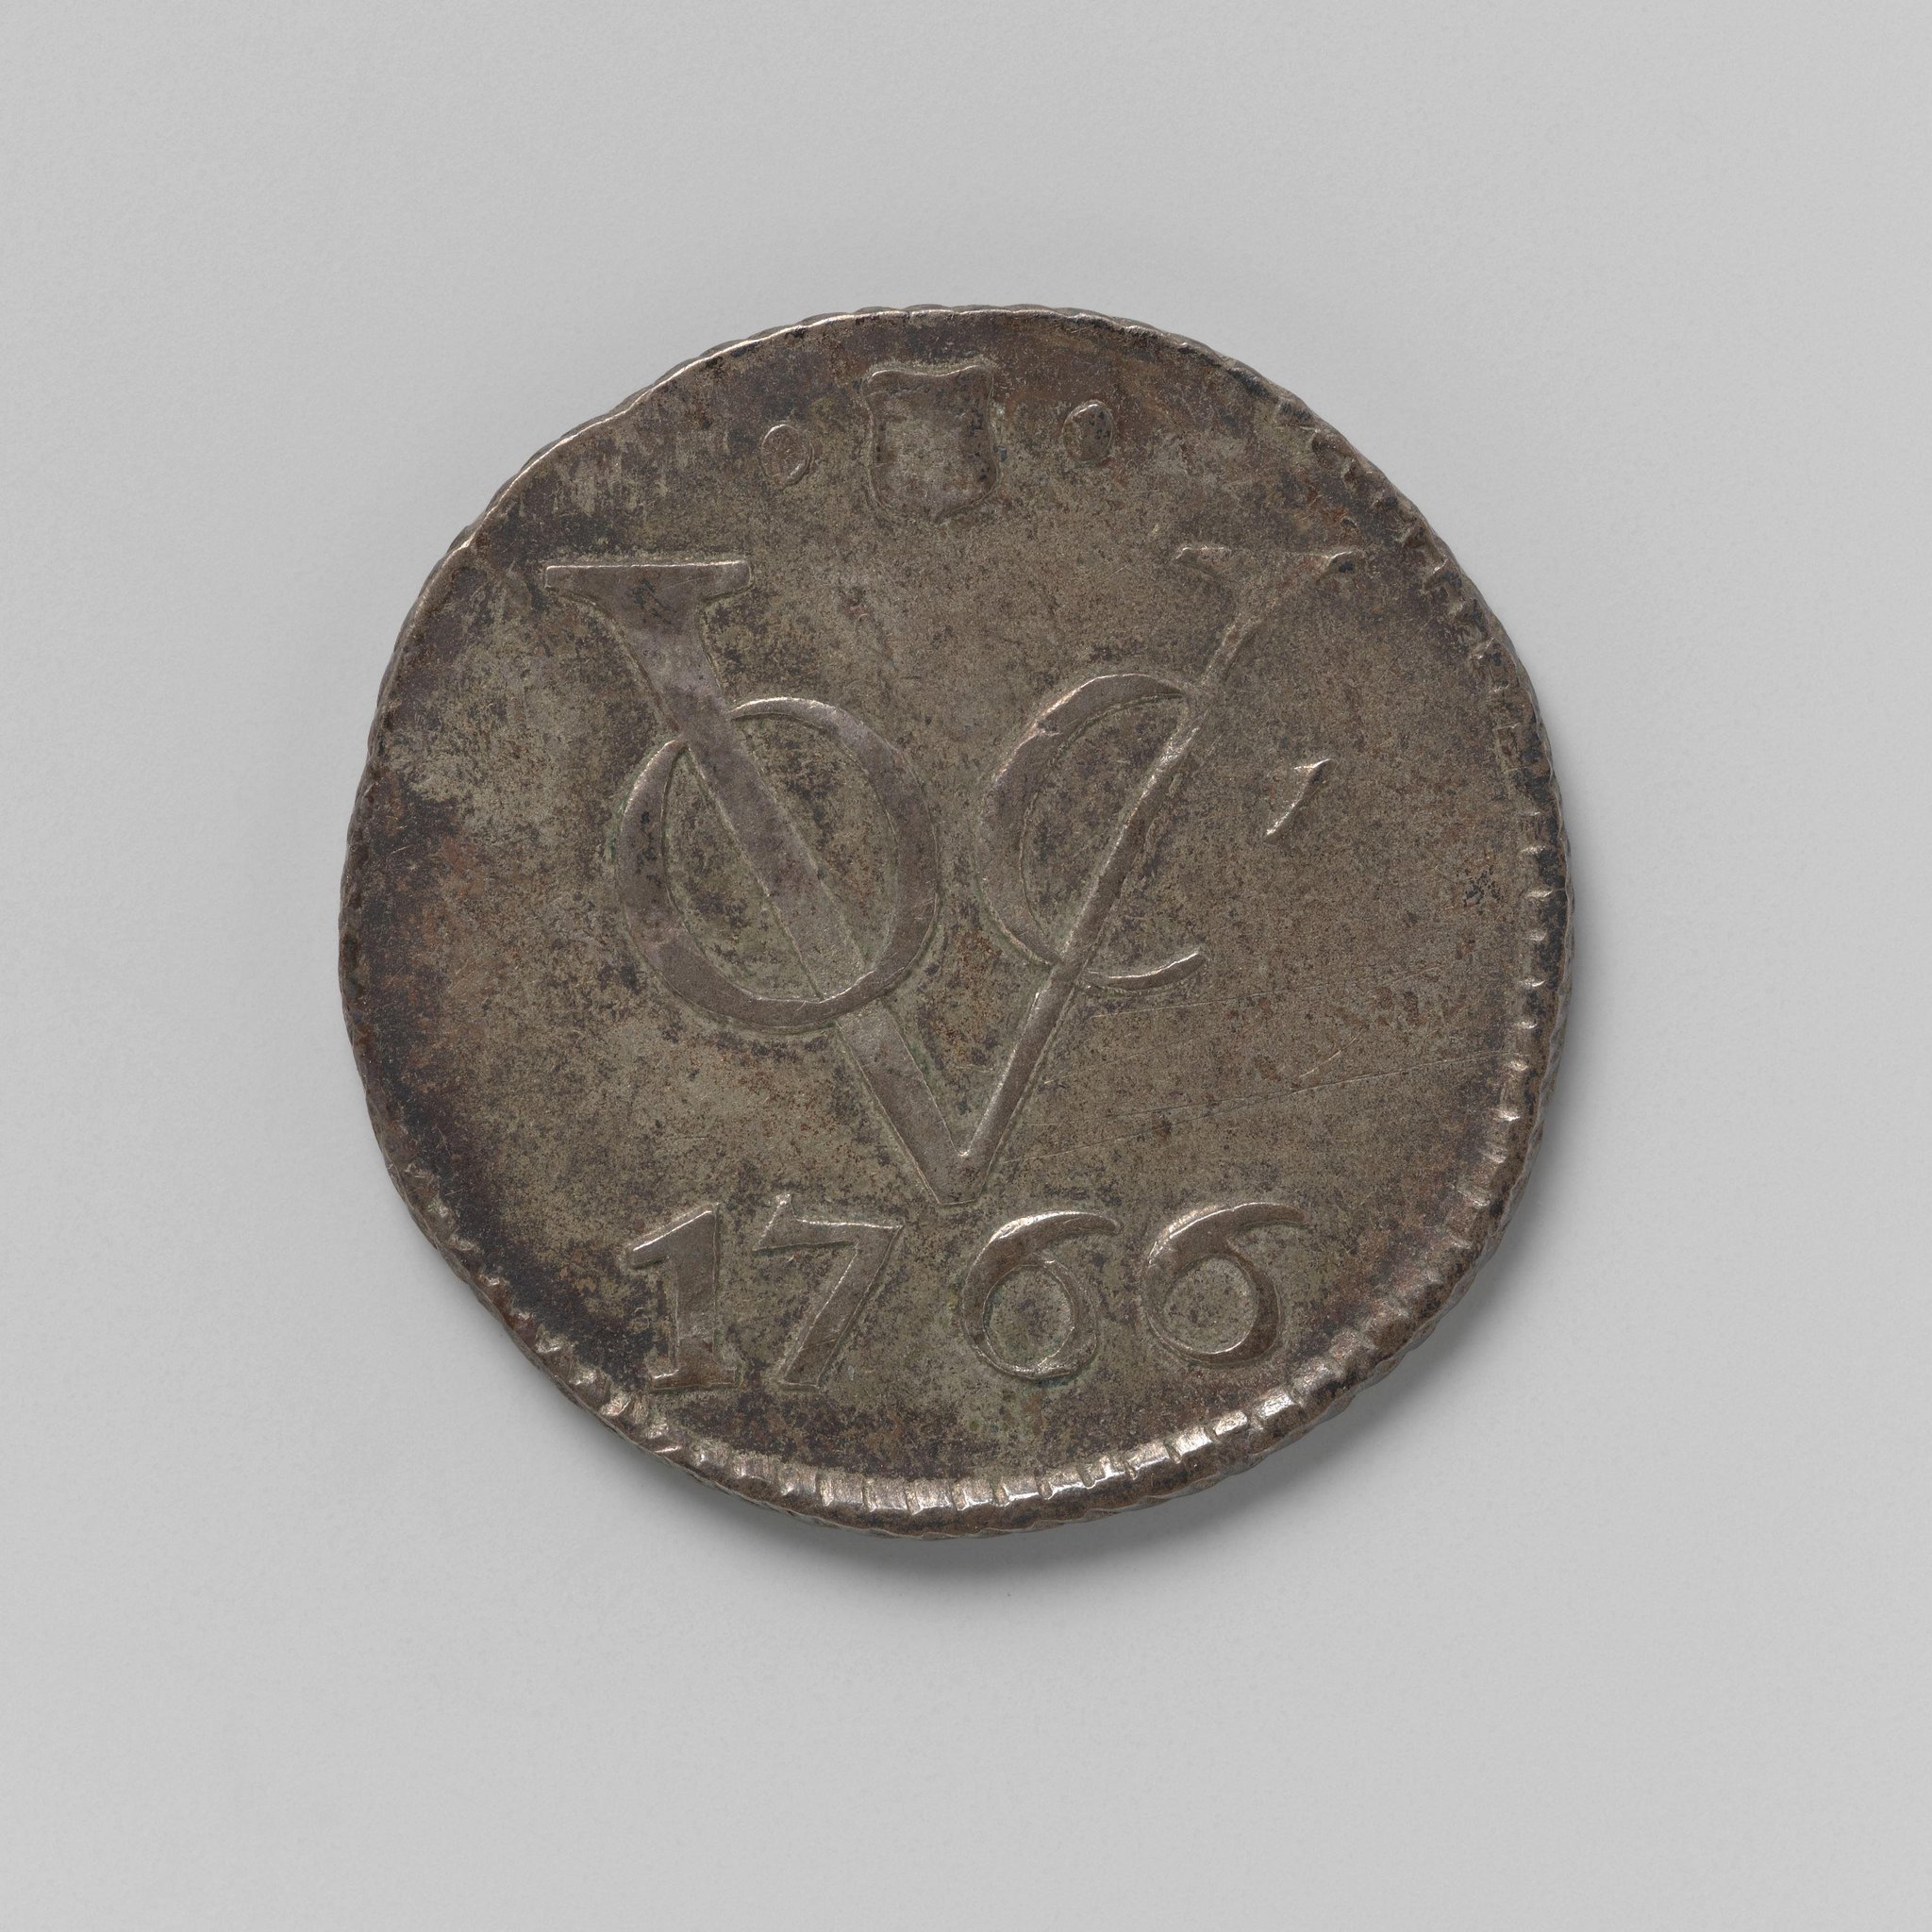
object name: coin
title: VOC, duit, stad Utrecht,1766. Afslag in zilver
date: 1766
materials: silver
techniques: striking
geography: utrecht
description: Zilveren munt. Voorzijde: op balk, waaronder guirlande, staand, door twee leeuwen gehouden gekroond wapenschild van de stad Utrecht. Keerzijde: monogram van de VOC, waarboven muntteken en waaronder jaartal. Kabelrand.